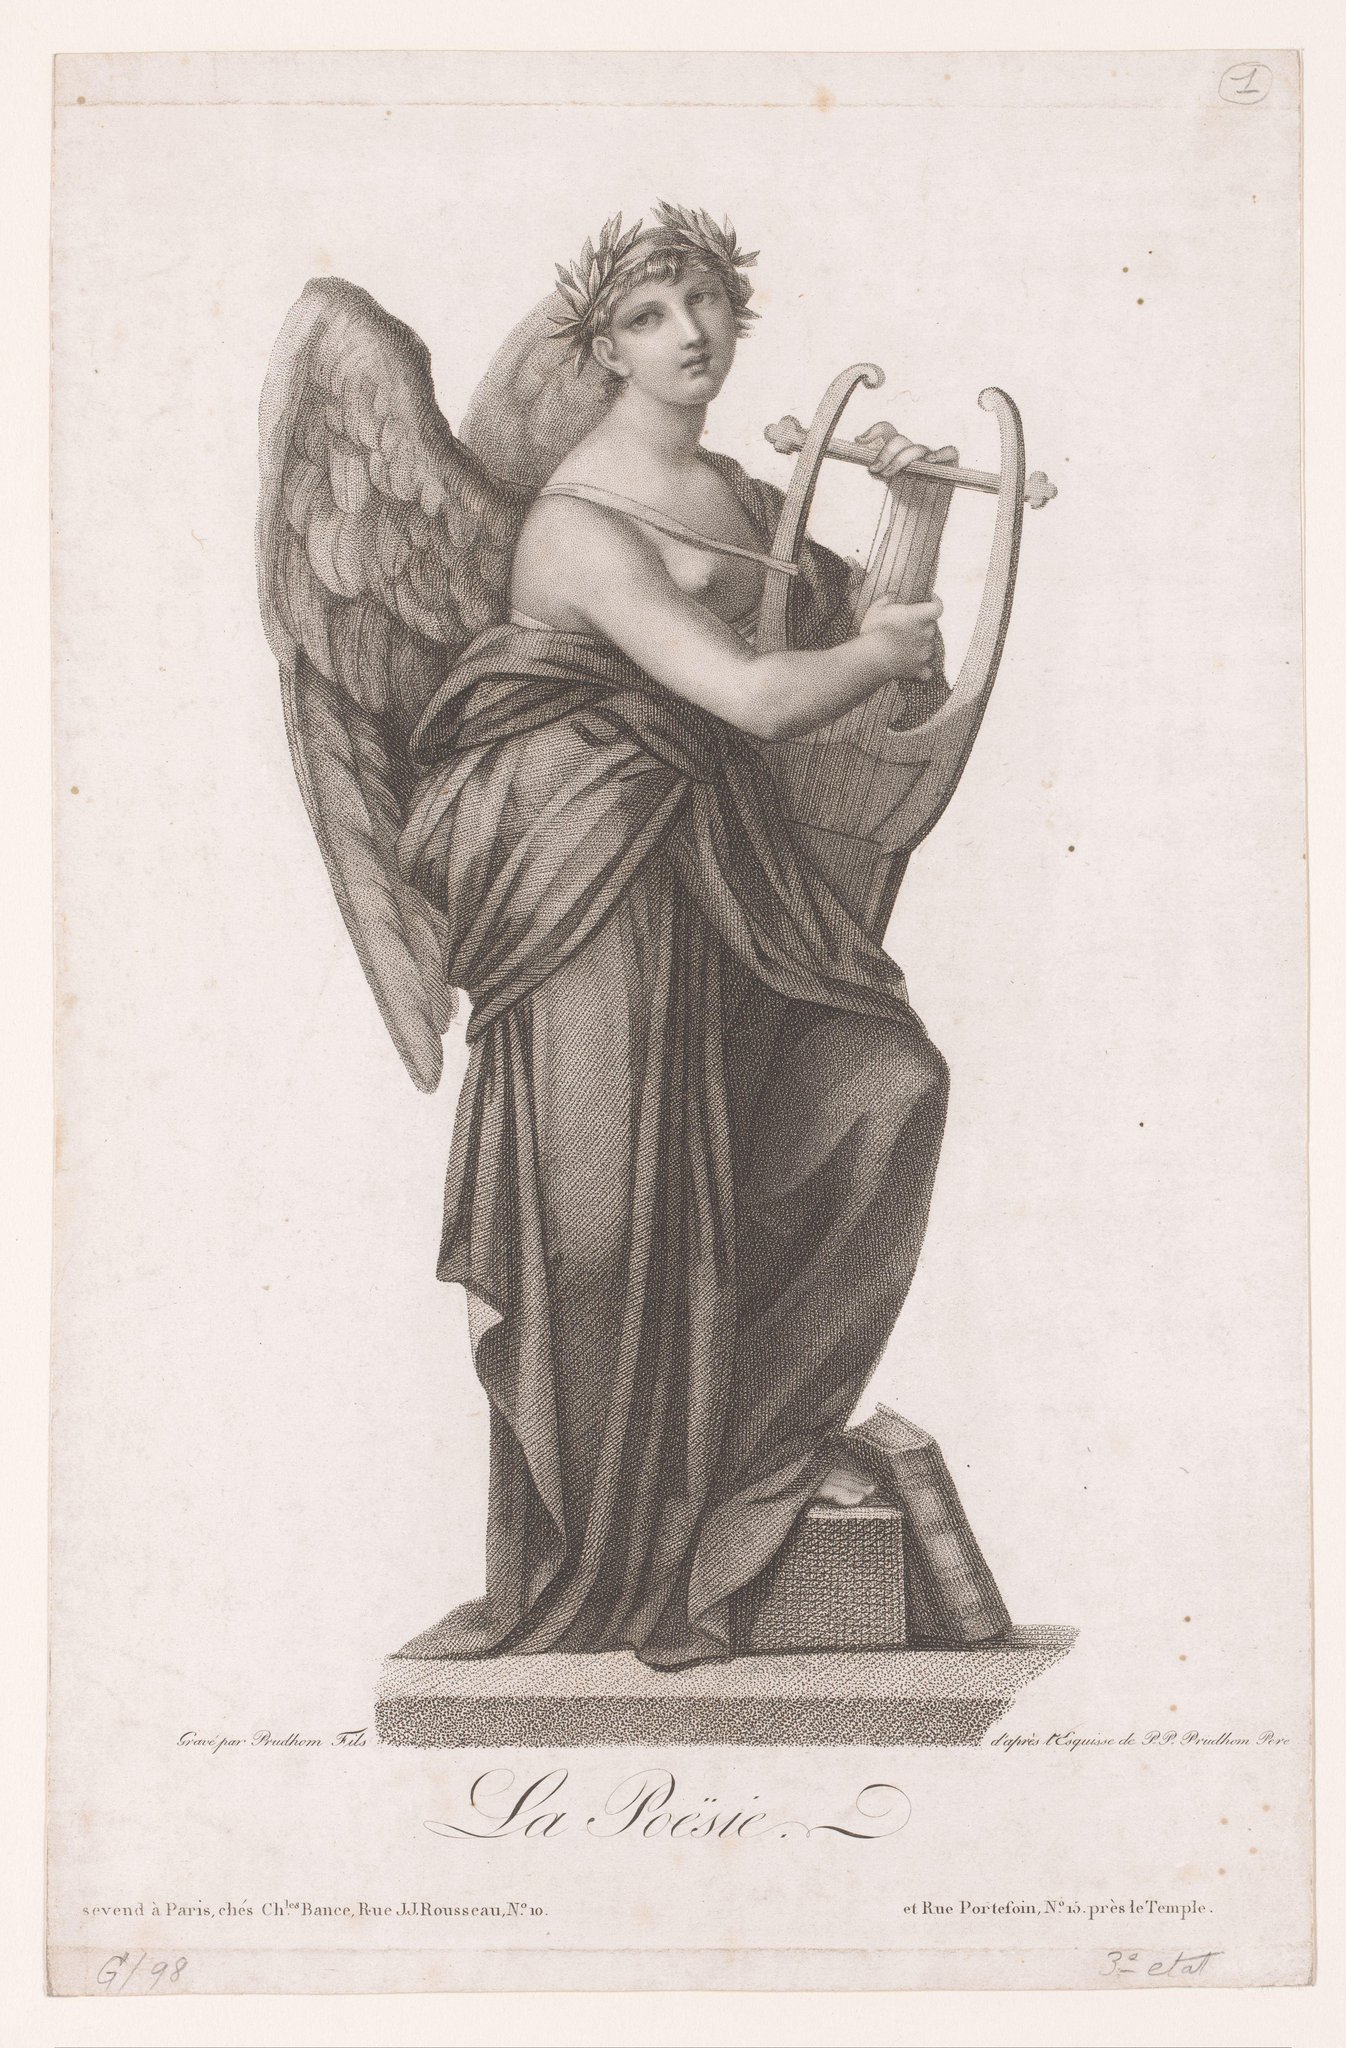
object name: print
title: Decoraties voor het stadhuis tijdens het huwelijk van Napoleon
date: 1810-1823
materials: paper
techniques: engraving, etching, roulette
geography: paris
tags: symbolic representations, allegories and emblems ~ poetry; 'poesia' (ripa)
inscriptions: collector's mark: Lugt 2228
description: Serie naar de figuren die als decoratie gebruikt zijn in het stadhuis, tijdens het huwelijk van Napoleon I Bonaparte en Marie Louise van Oostenrijk in 1810.